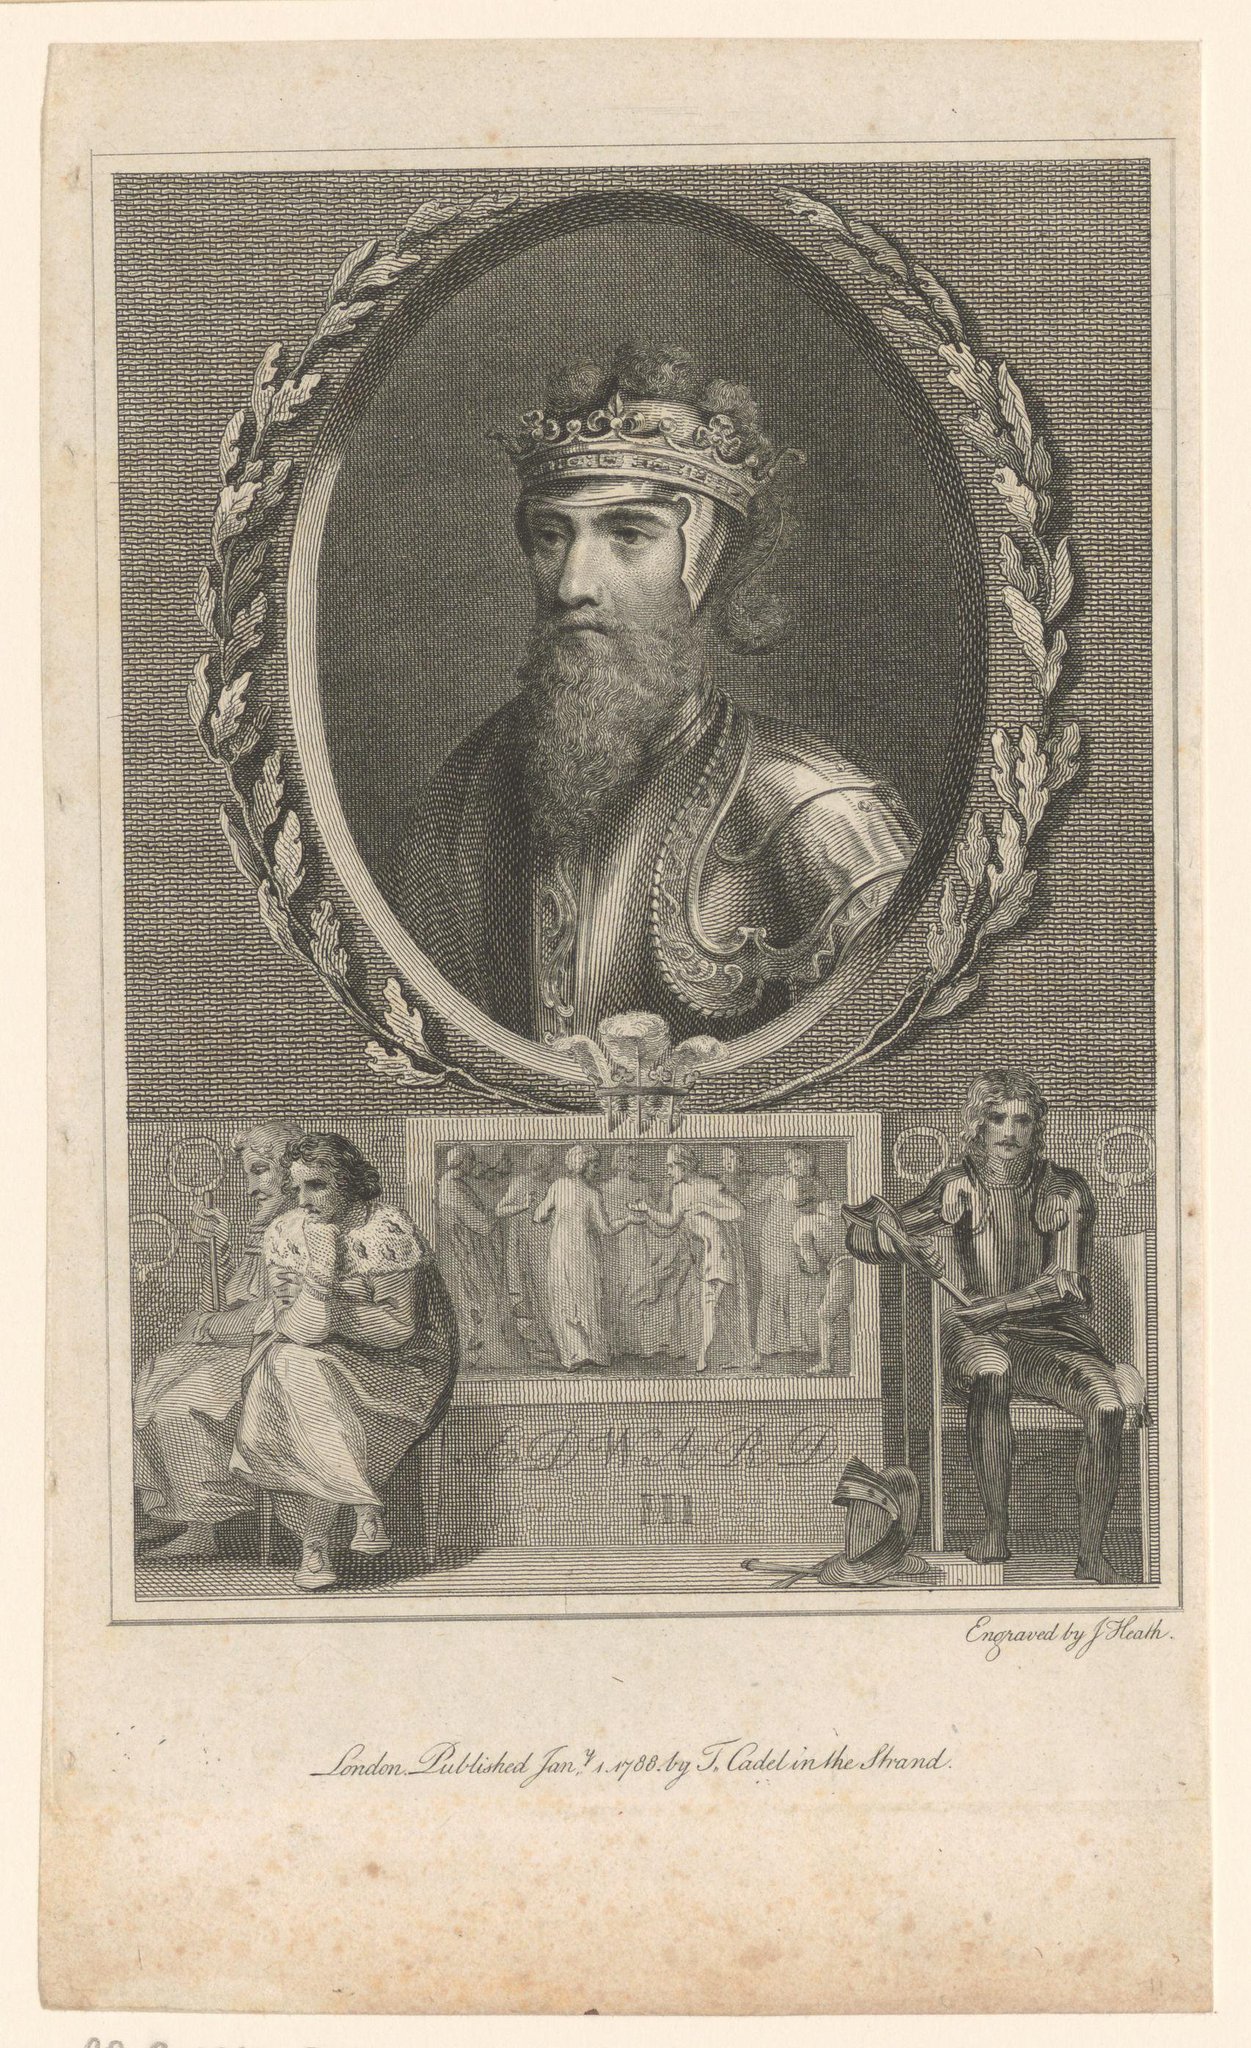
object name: book illustration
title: Edward III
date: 1701-1788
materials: paper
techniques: etching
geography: london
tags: historical persons, king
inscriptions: collector's mark: Lugt 2228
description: Prent uit: Hume, David. History of England (...). Londen: Thomas Cadell, 1789, dl. 2, p. 371.